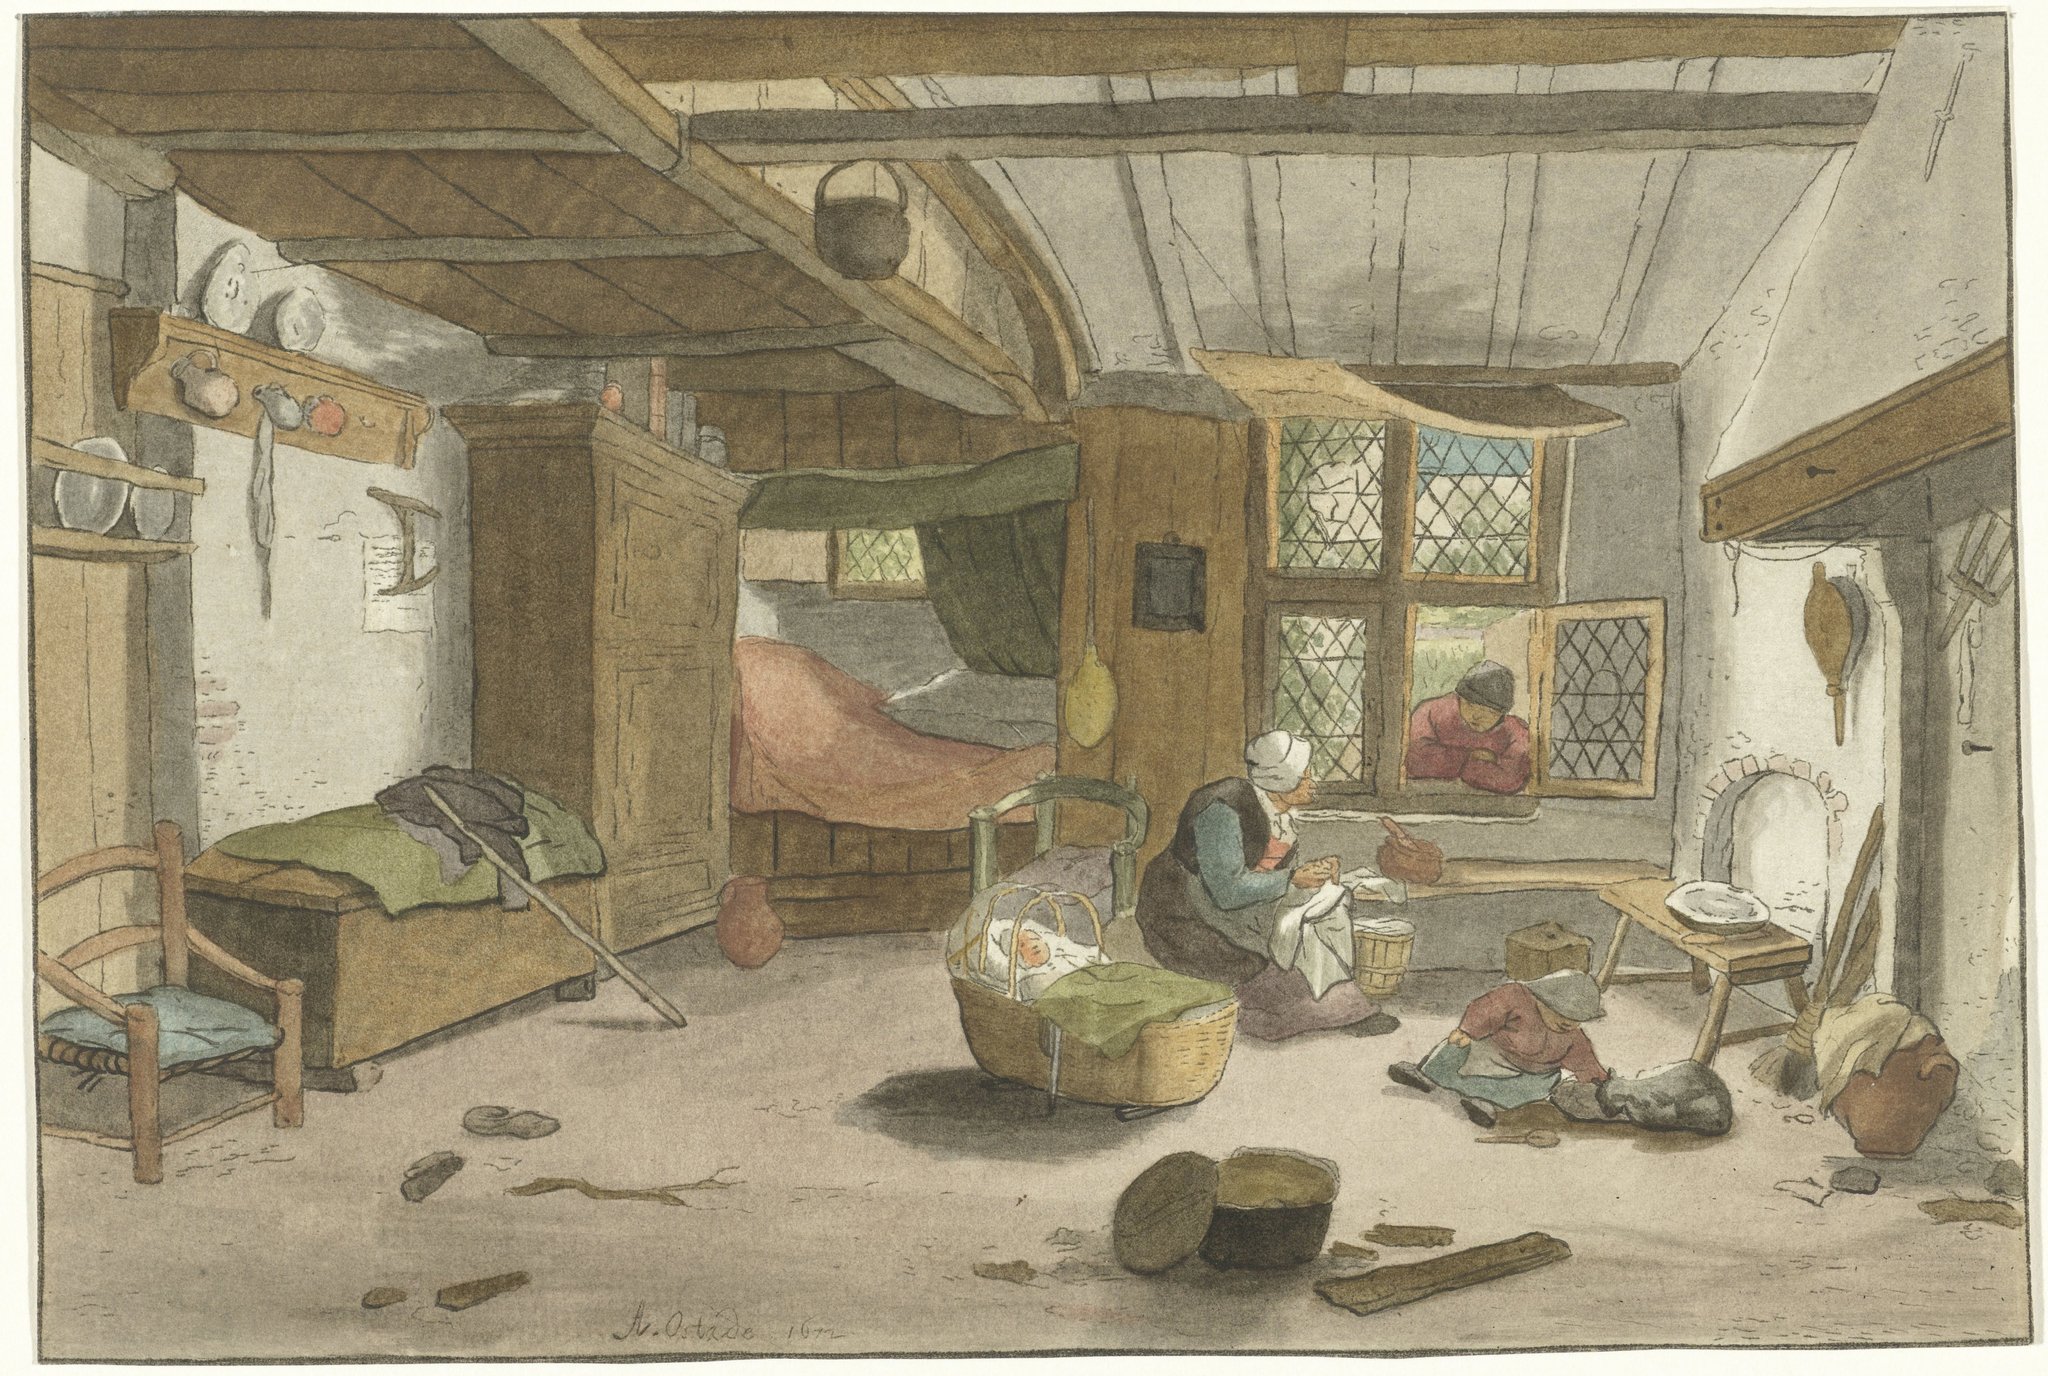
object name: print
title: Interieur met vrouw bij wieg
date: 1760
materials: paper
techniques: hand coloring, roulette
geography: amsterdam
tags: interior of the house, cradle, crib, human figure at (open) window, seen from inside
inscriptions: inscription: ‘Geoffreerd aan mijnen waarde vriend Den WEd Heer Hemsterhuis Blijvende zijn WEd Dienaar en vriend PvA / A v Ostade del Ploos v Amstel J.C. Fecit 1760’, collector's mark: Lugt 240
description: Interieur met een vrouw bij een wieg. De vrouw praat met een man, die buiten aan het open raam staat. Bij de haard speelt een kind.